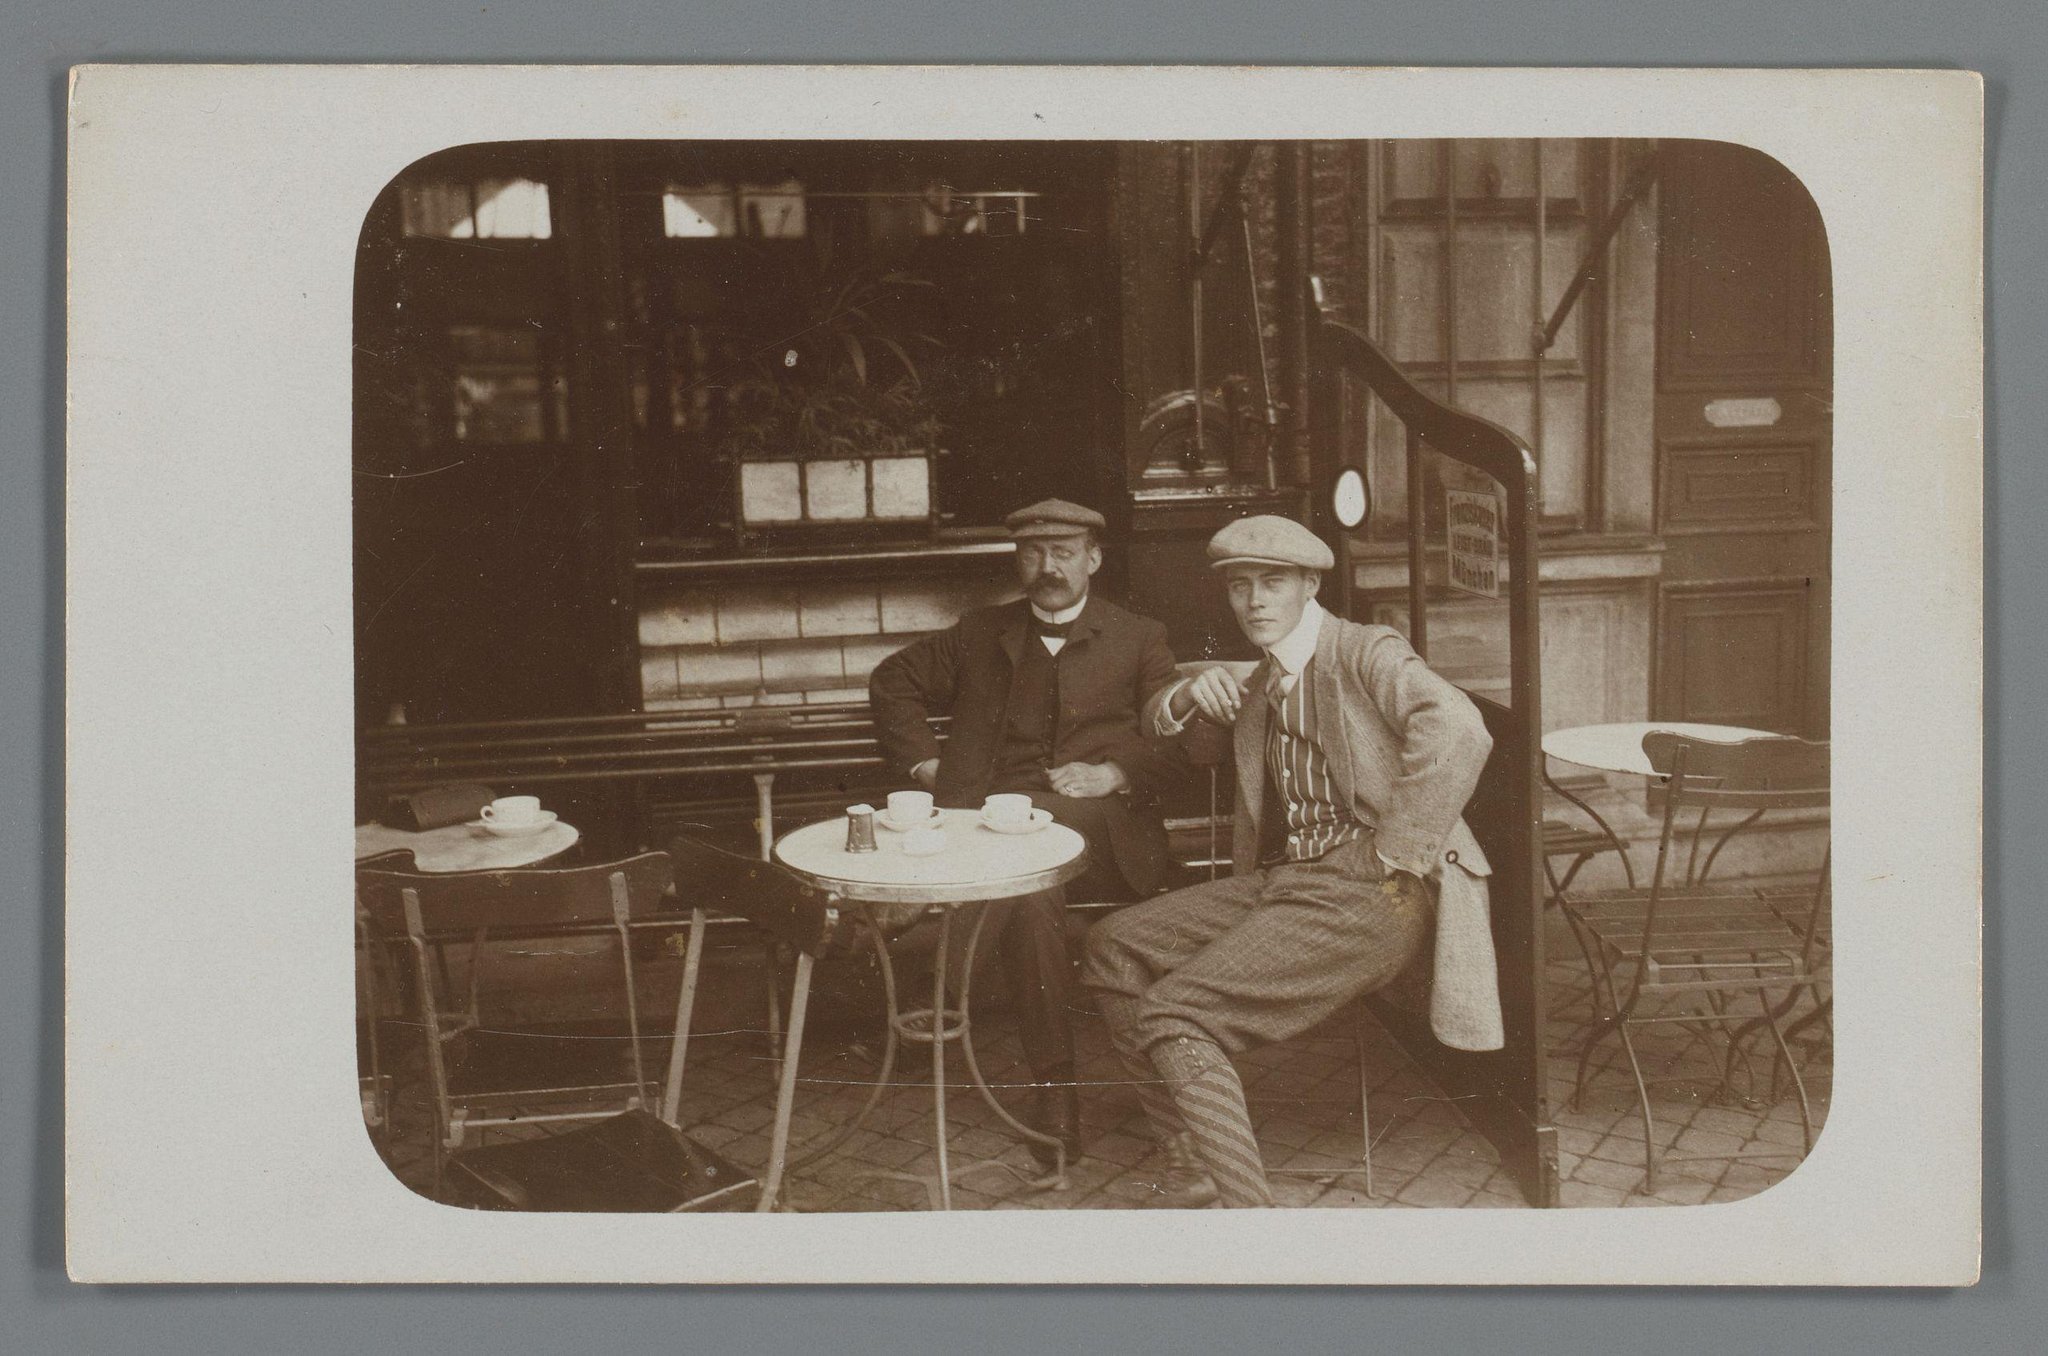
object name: ansichtkaart, prentbriefkaart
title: Willem de Jong met een onbekende jongeman op een caféterras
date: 1900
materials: paper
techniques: collodion silver print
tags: willem de jong (fotograaf), historical persons, pavement, terrace in front of inn or restaurant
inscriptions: number: ‘45/ XIII’, inscription: ‘WDJ (achter)’